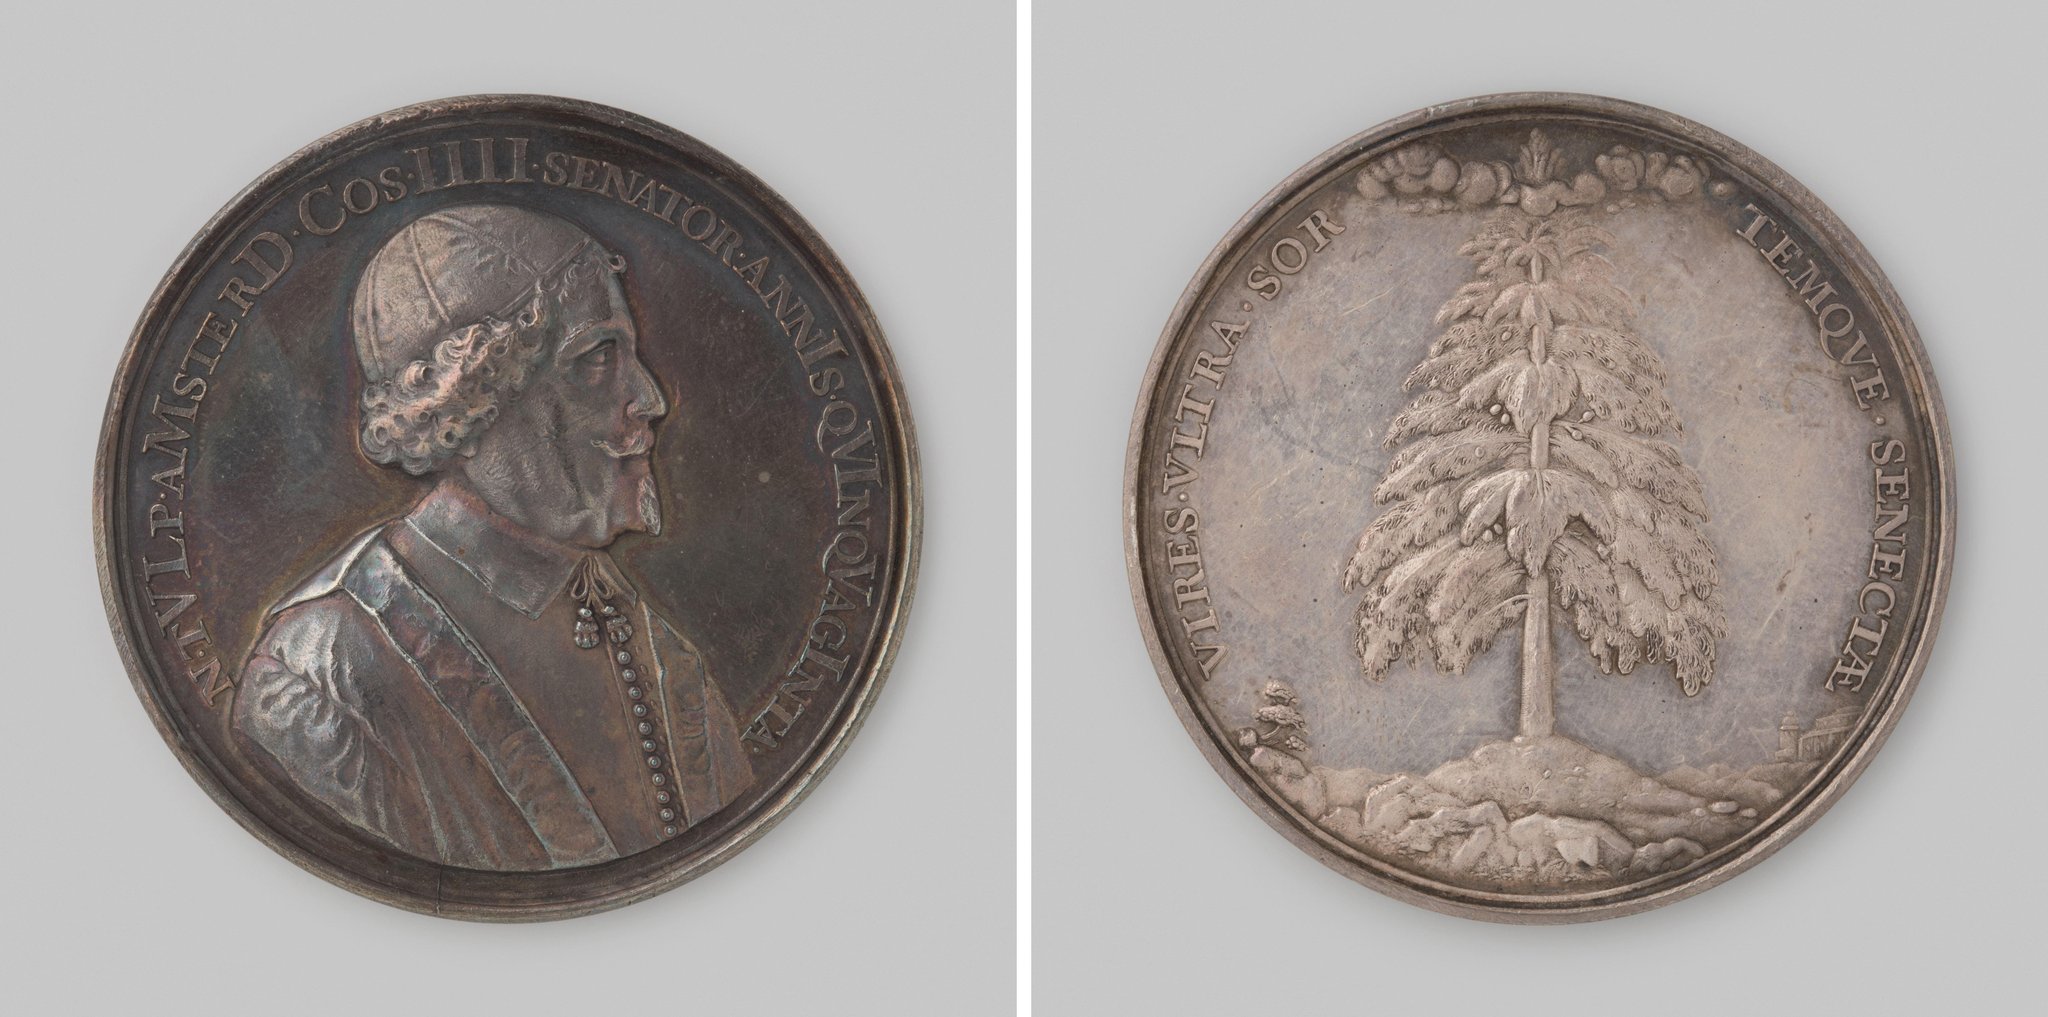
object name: history medal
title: Nicolaas Tulp burgemeester van Amsterdam 1672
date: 1672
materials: silver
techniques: striking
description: Zilveren penning, op de voorzijde het borstbeeld van Tulp naar rechts, met omschrift, op de keerzijde een plataan die door de wolken groeit, met omschrift.